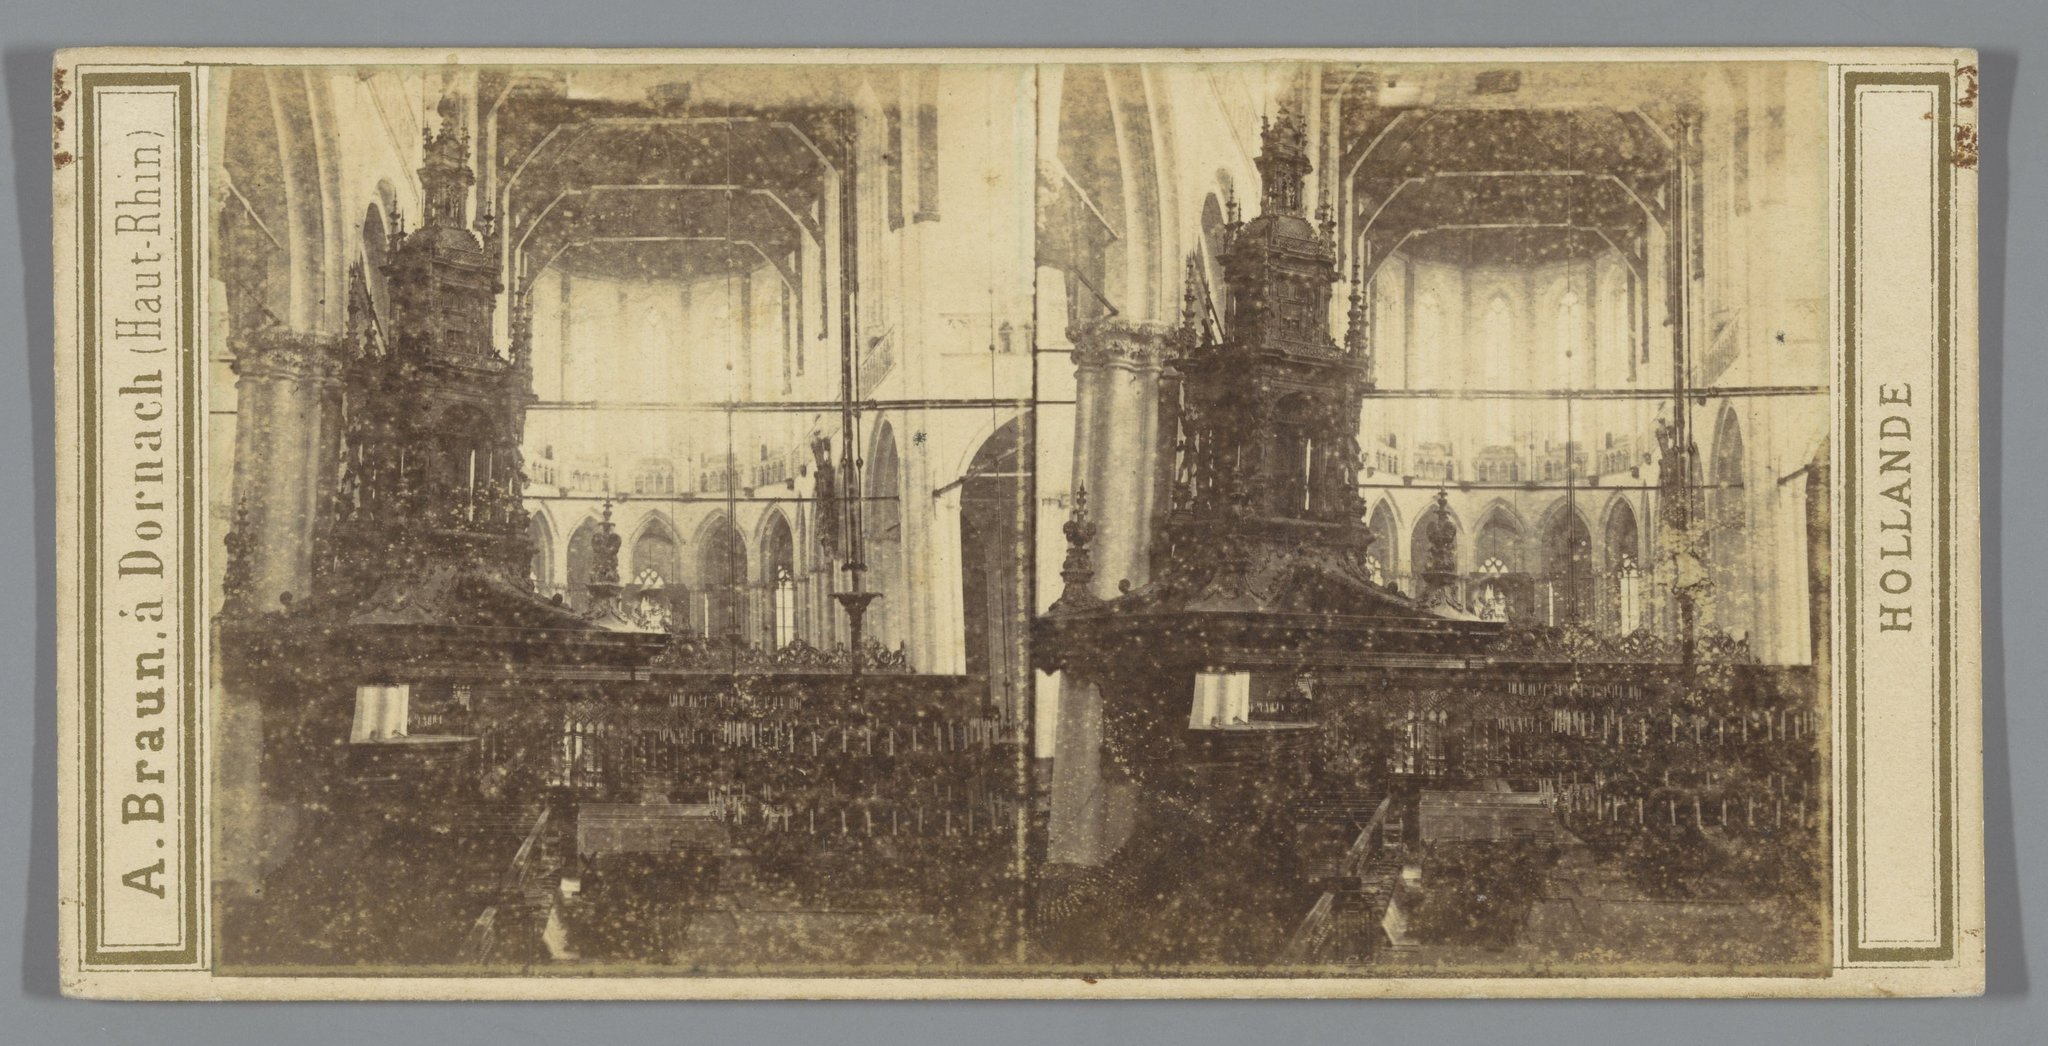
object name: stereograph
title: Hollande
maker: gaston braun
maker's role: fotograaf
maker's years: 1845-1928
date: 1864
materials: cardboard, paper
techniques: albumen print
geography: dornach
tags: interior of church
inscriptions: number: ‘No 3939.’